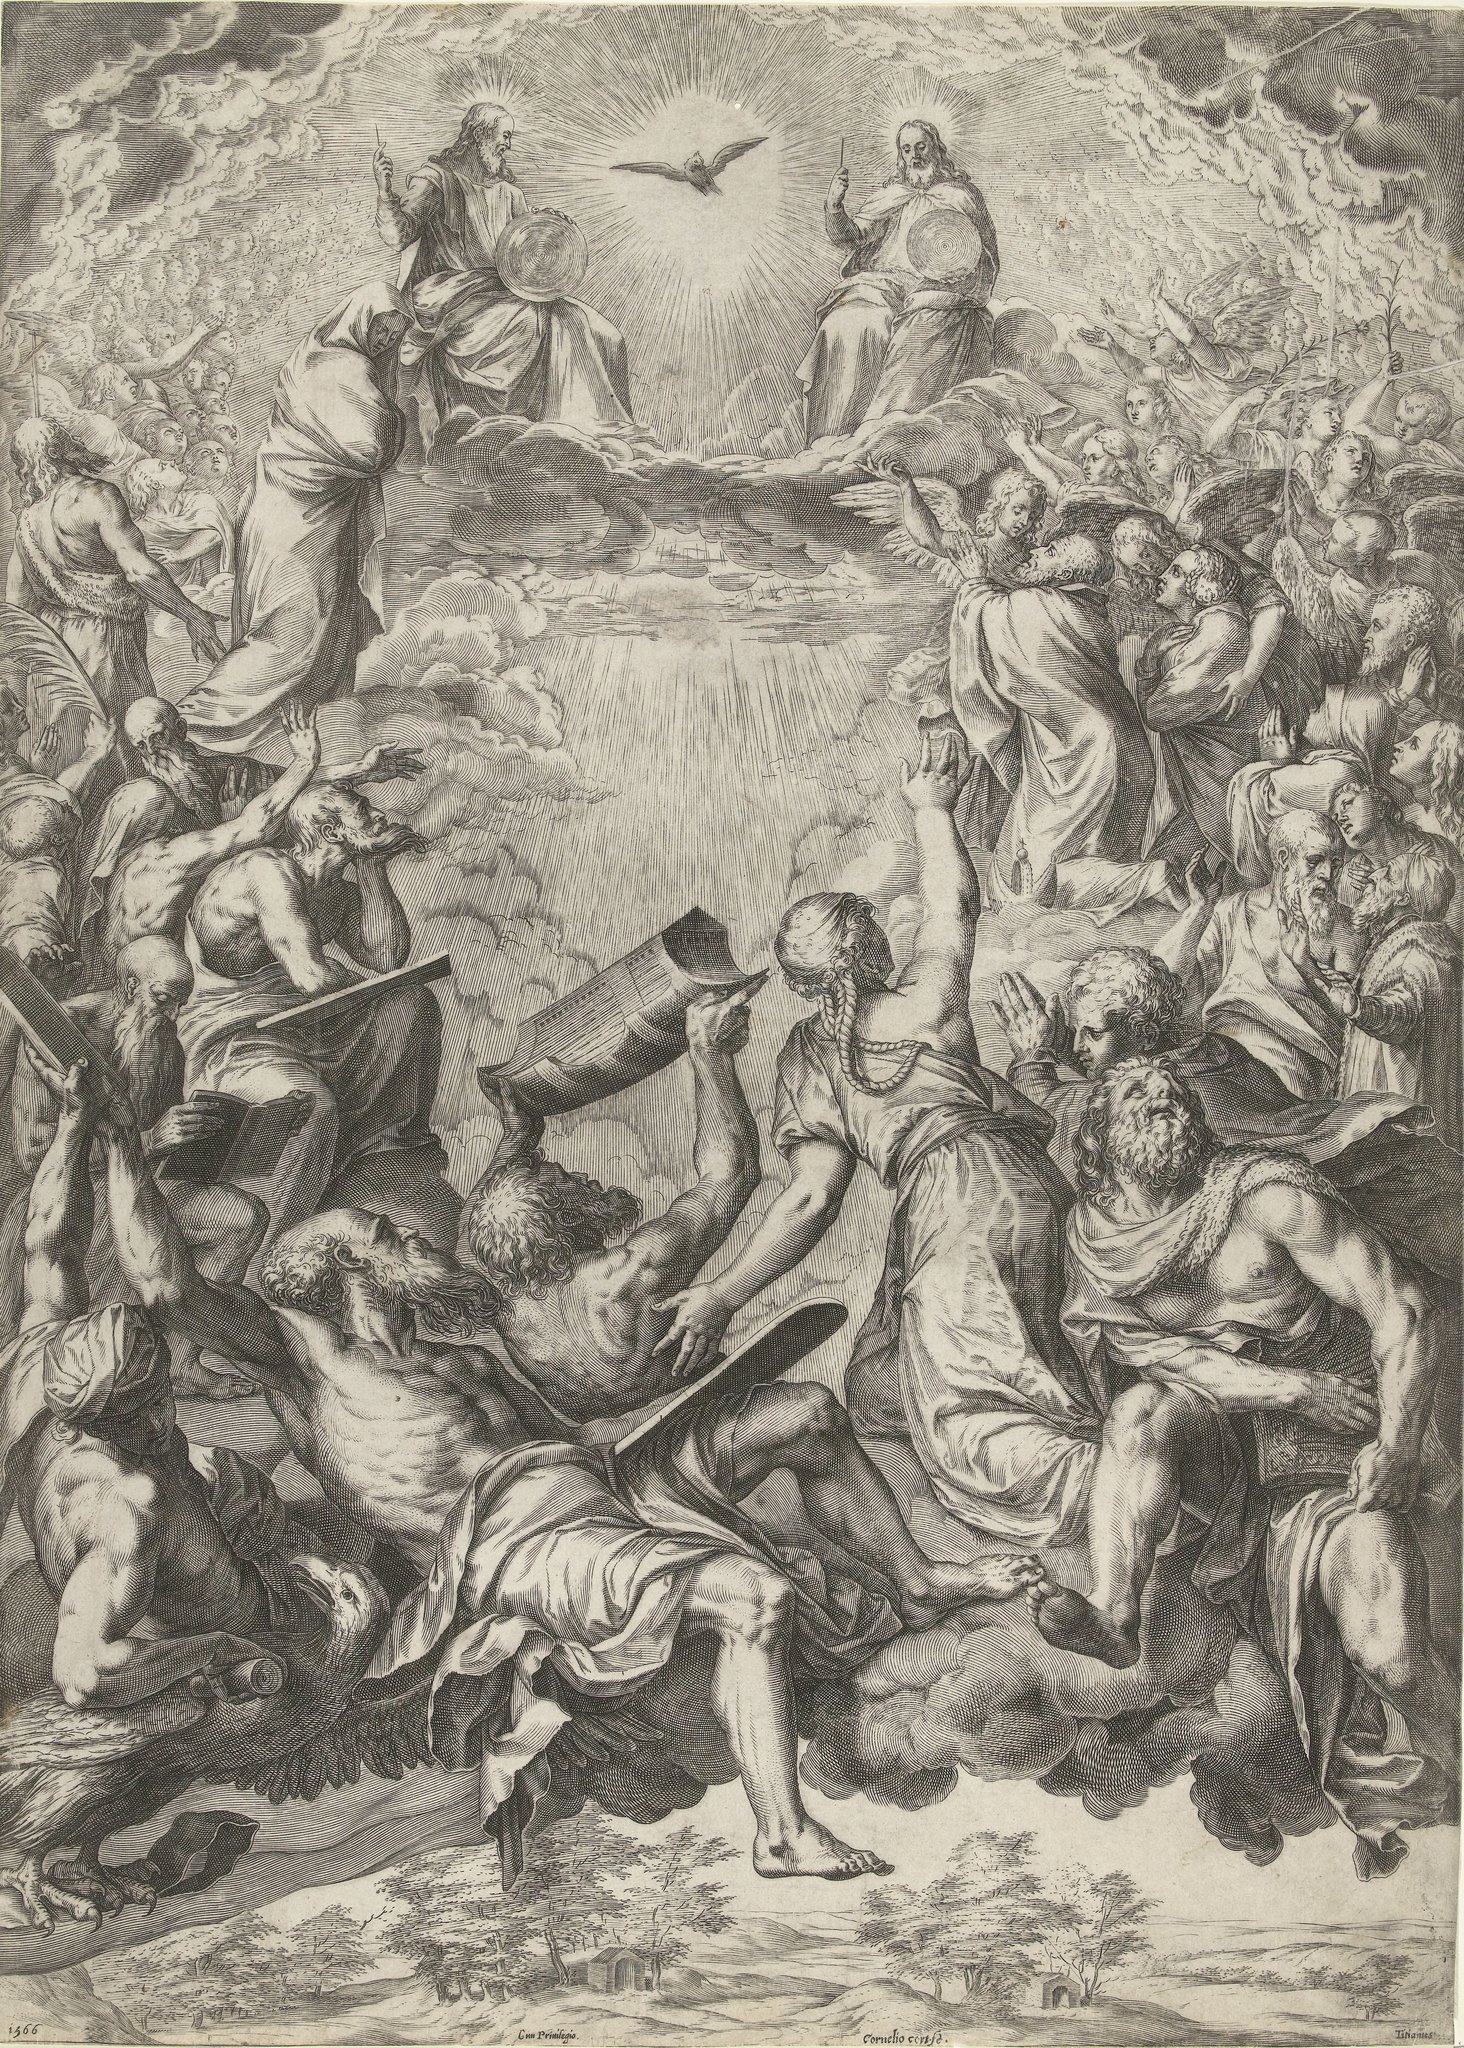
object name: print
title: Triomf van de Heilige Drieëenheid (La Gloria)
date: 1566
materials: paper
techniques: engraving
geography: rome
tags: story of noah, moses (not in biblical context); possible attributes: rays of light or horns on his head, rod, tables of the law, angels in adoration, trinity in which god the father and christ are represented as persons, the holy ghost as dove (+ donor(s), supplicant(s), whether or not with patron saint(s)), persons from the old testament (not in biblical context, nor occurring in legendary/historical extensions included in division 71)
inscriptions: collector's mark: Lugt 2228, signature: ‘Cornelio cort. fe.’, privilege: ‘Cun[sic] Privilegio’, signature: ‘Titianus’, date: ‘1566’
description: De Heilige Drieëenheid middenboven in de wolken: God als zittende oude man met wereldbol, Christus als zittende man met wereldbol, de Heilige Geest in de gedaante van een duif. Engelenkoren en figuren uit het Oude Testament aanbidden de Drieëenheid. Middenonder Noach met de ark in zijn handen en Mozes met de stenen tafelen.